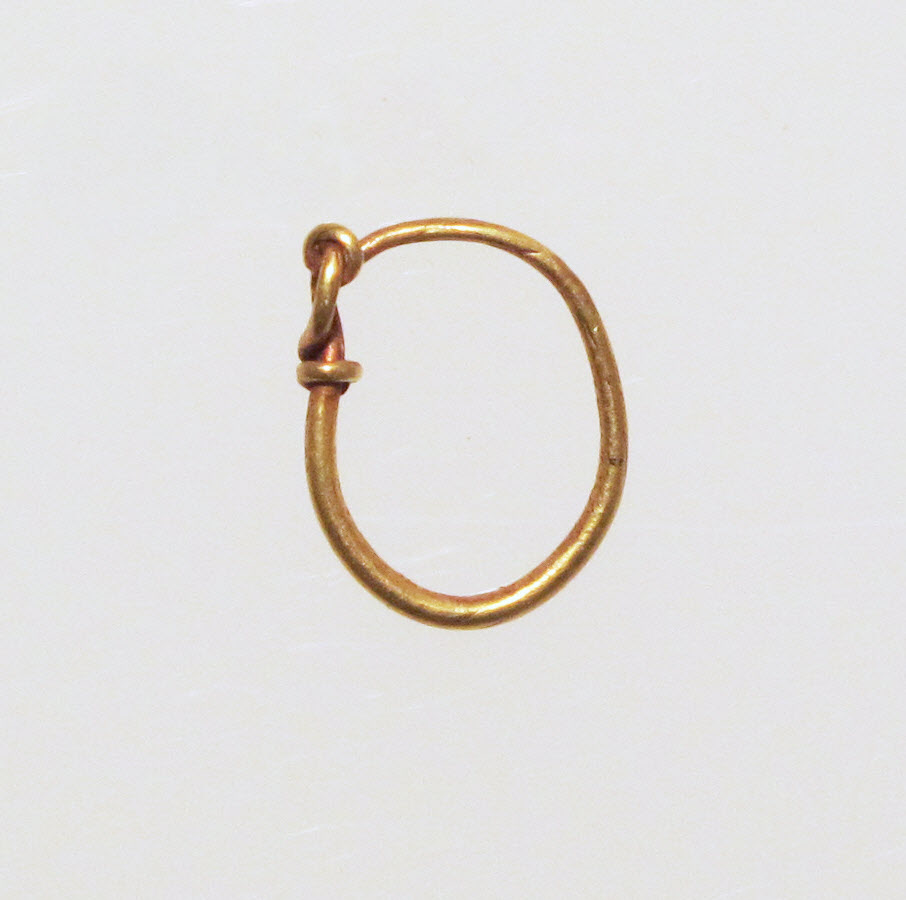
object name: earring loop type, plain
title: Gold loop earring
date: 7000 BCE-330 CE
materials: gold